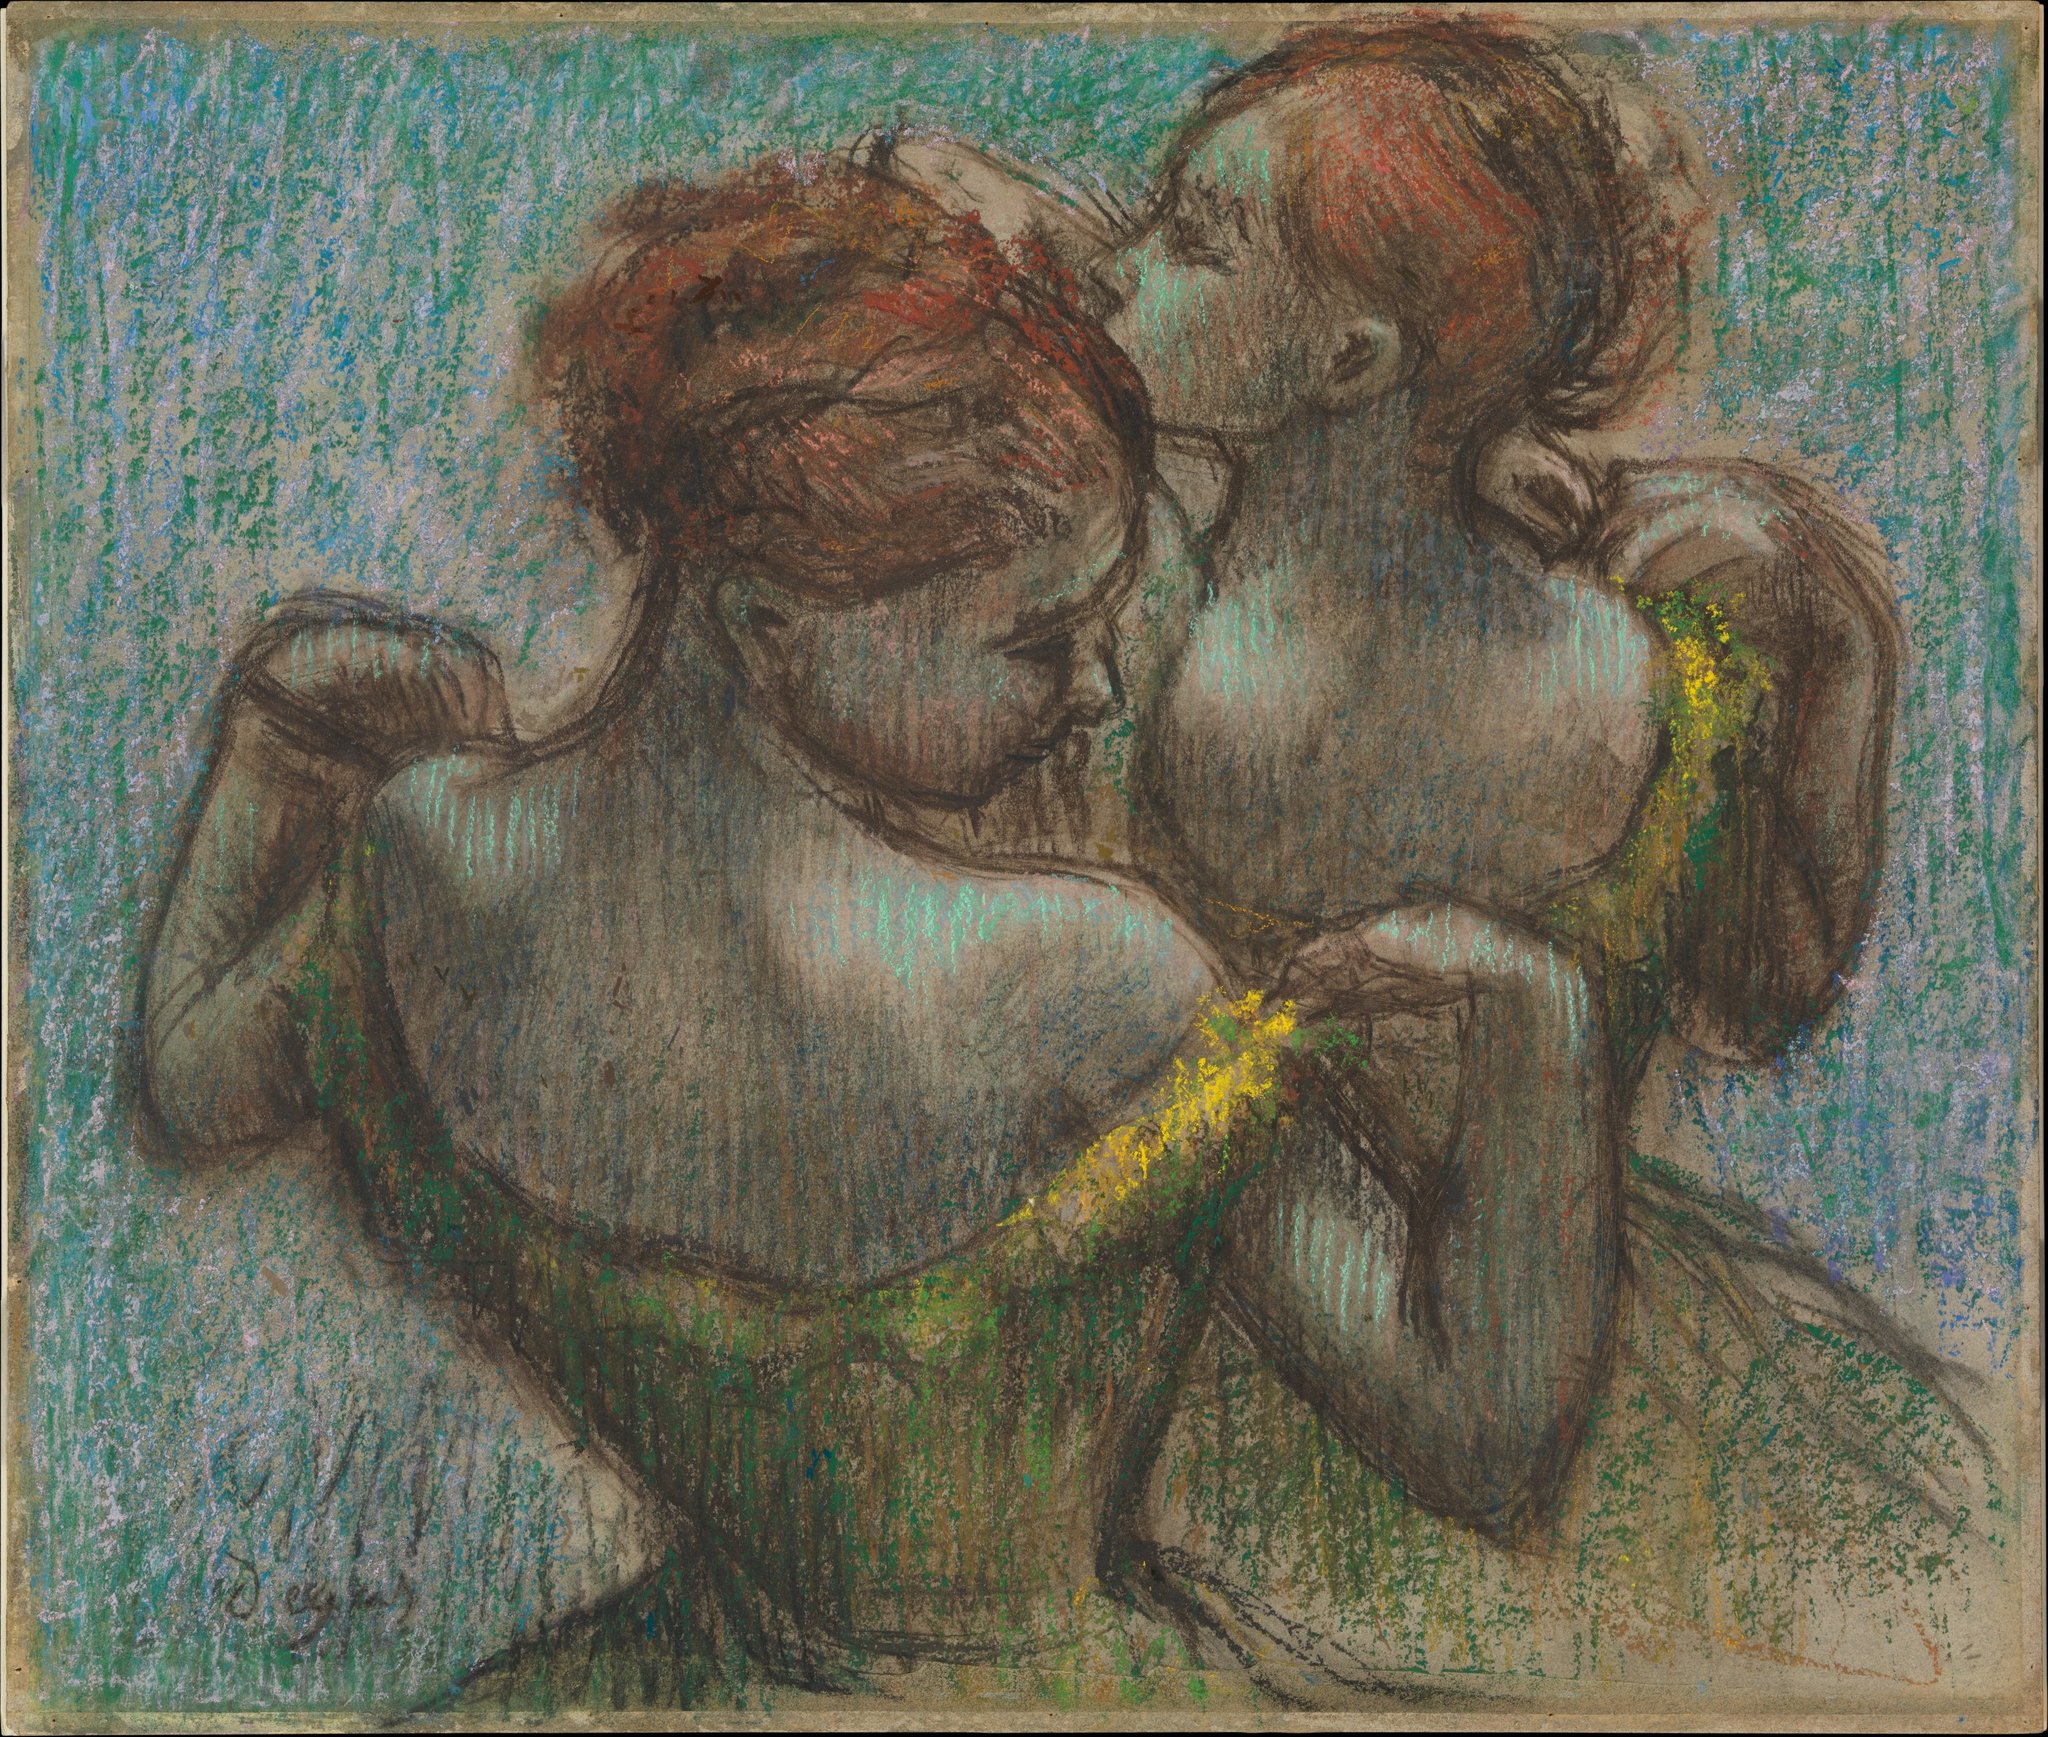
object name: drawing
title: Two Dancers, Half-length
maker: edgar degas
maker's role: artist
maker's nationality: french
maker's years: 1834-1917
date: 1854-1917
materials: cardboard, charcoal, pastel, paper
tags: women,dancers,ballet